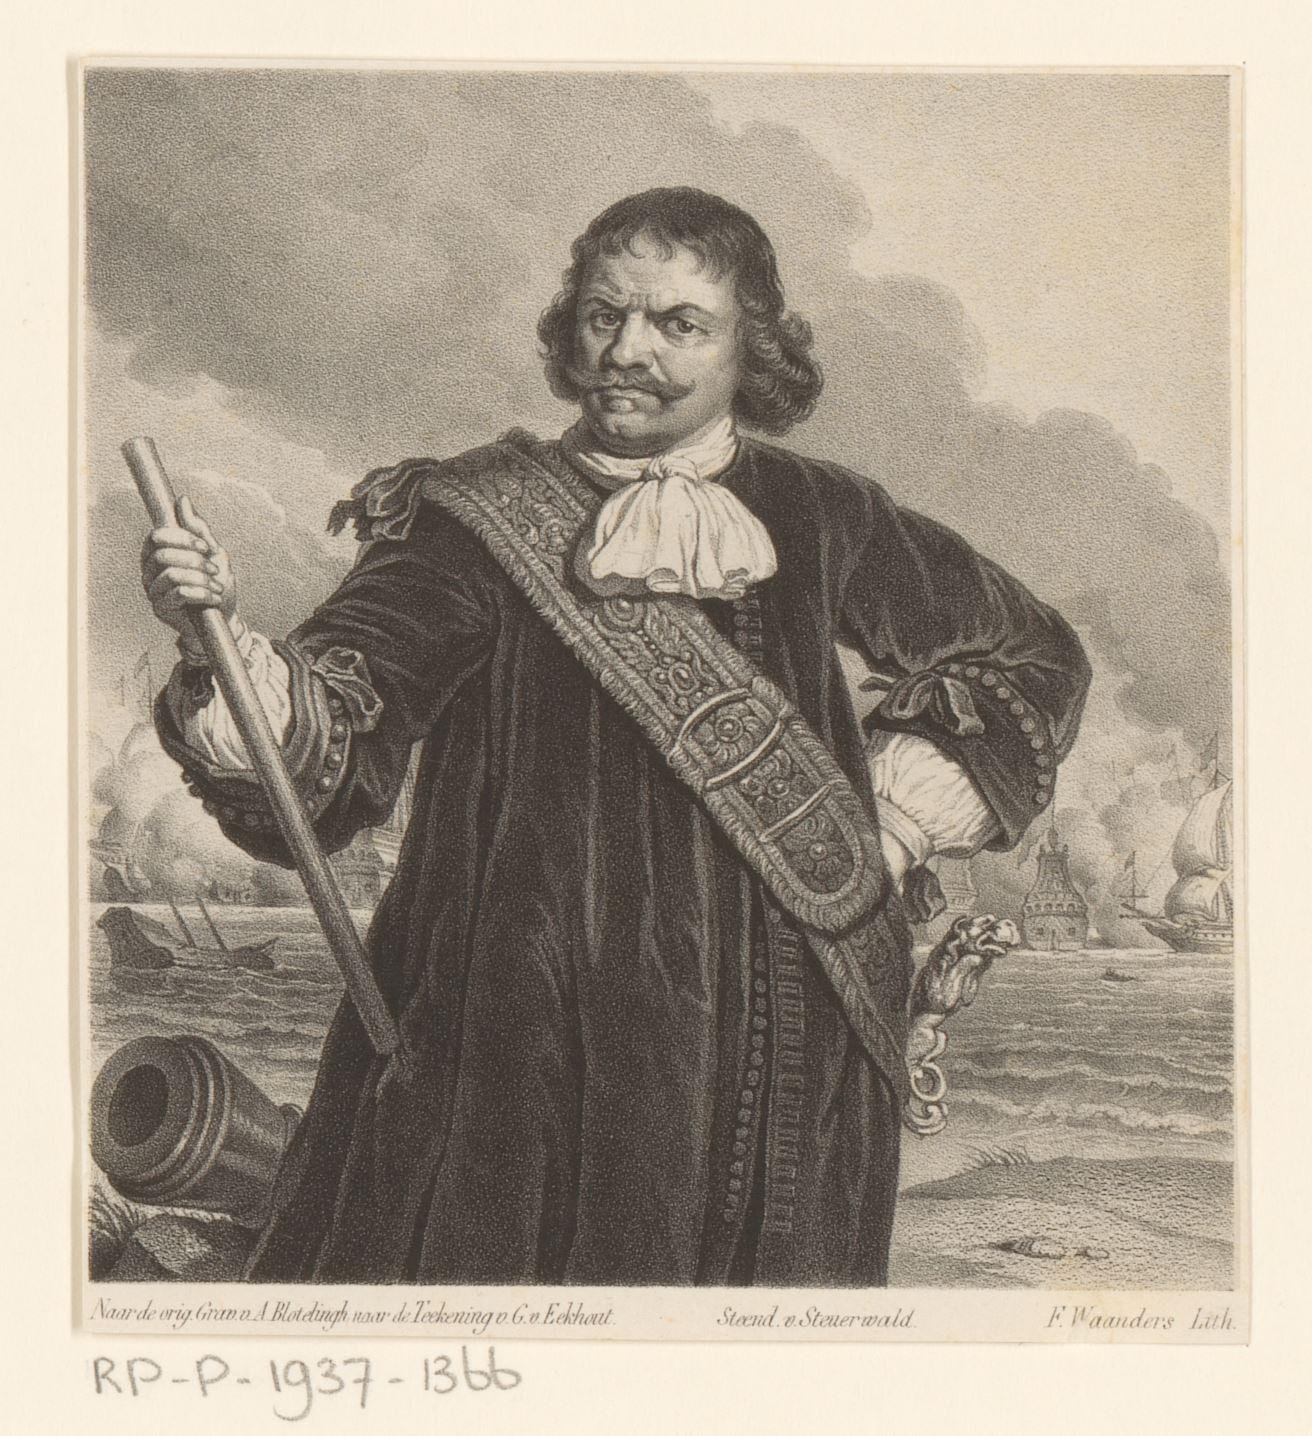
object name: print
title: Portret van Tjerck Hiddes de Vries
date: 1833-1863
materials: paper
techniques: lithograph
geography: the hague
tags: historical persons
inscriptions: collector's mark: Lugt 2228